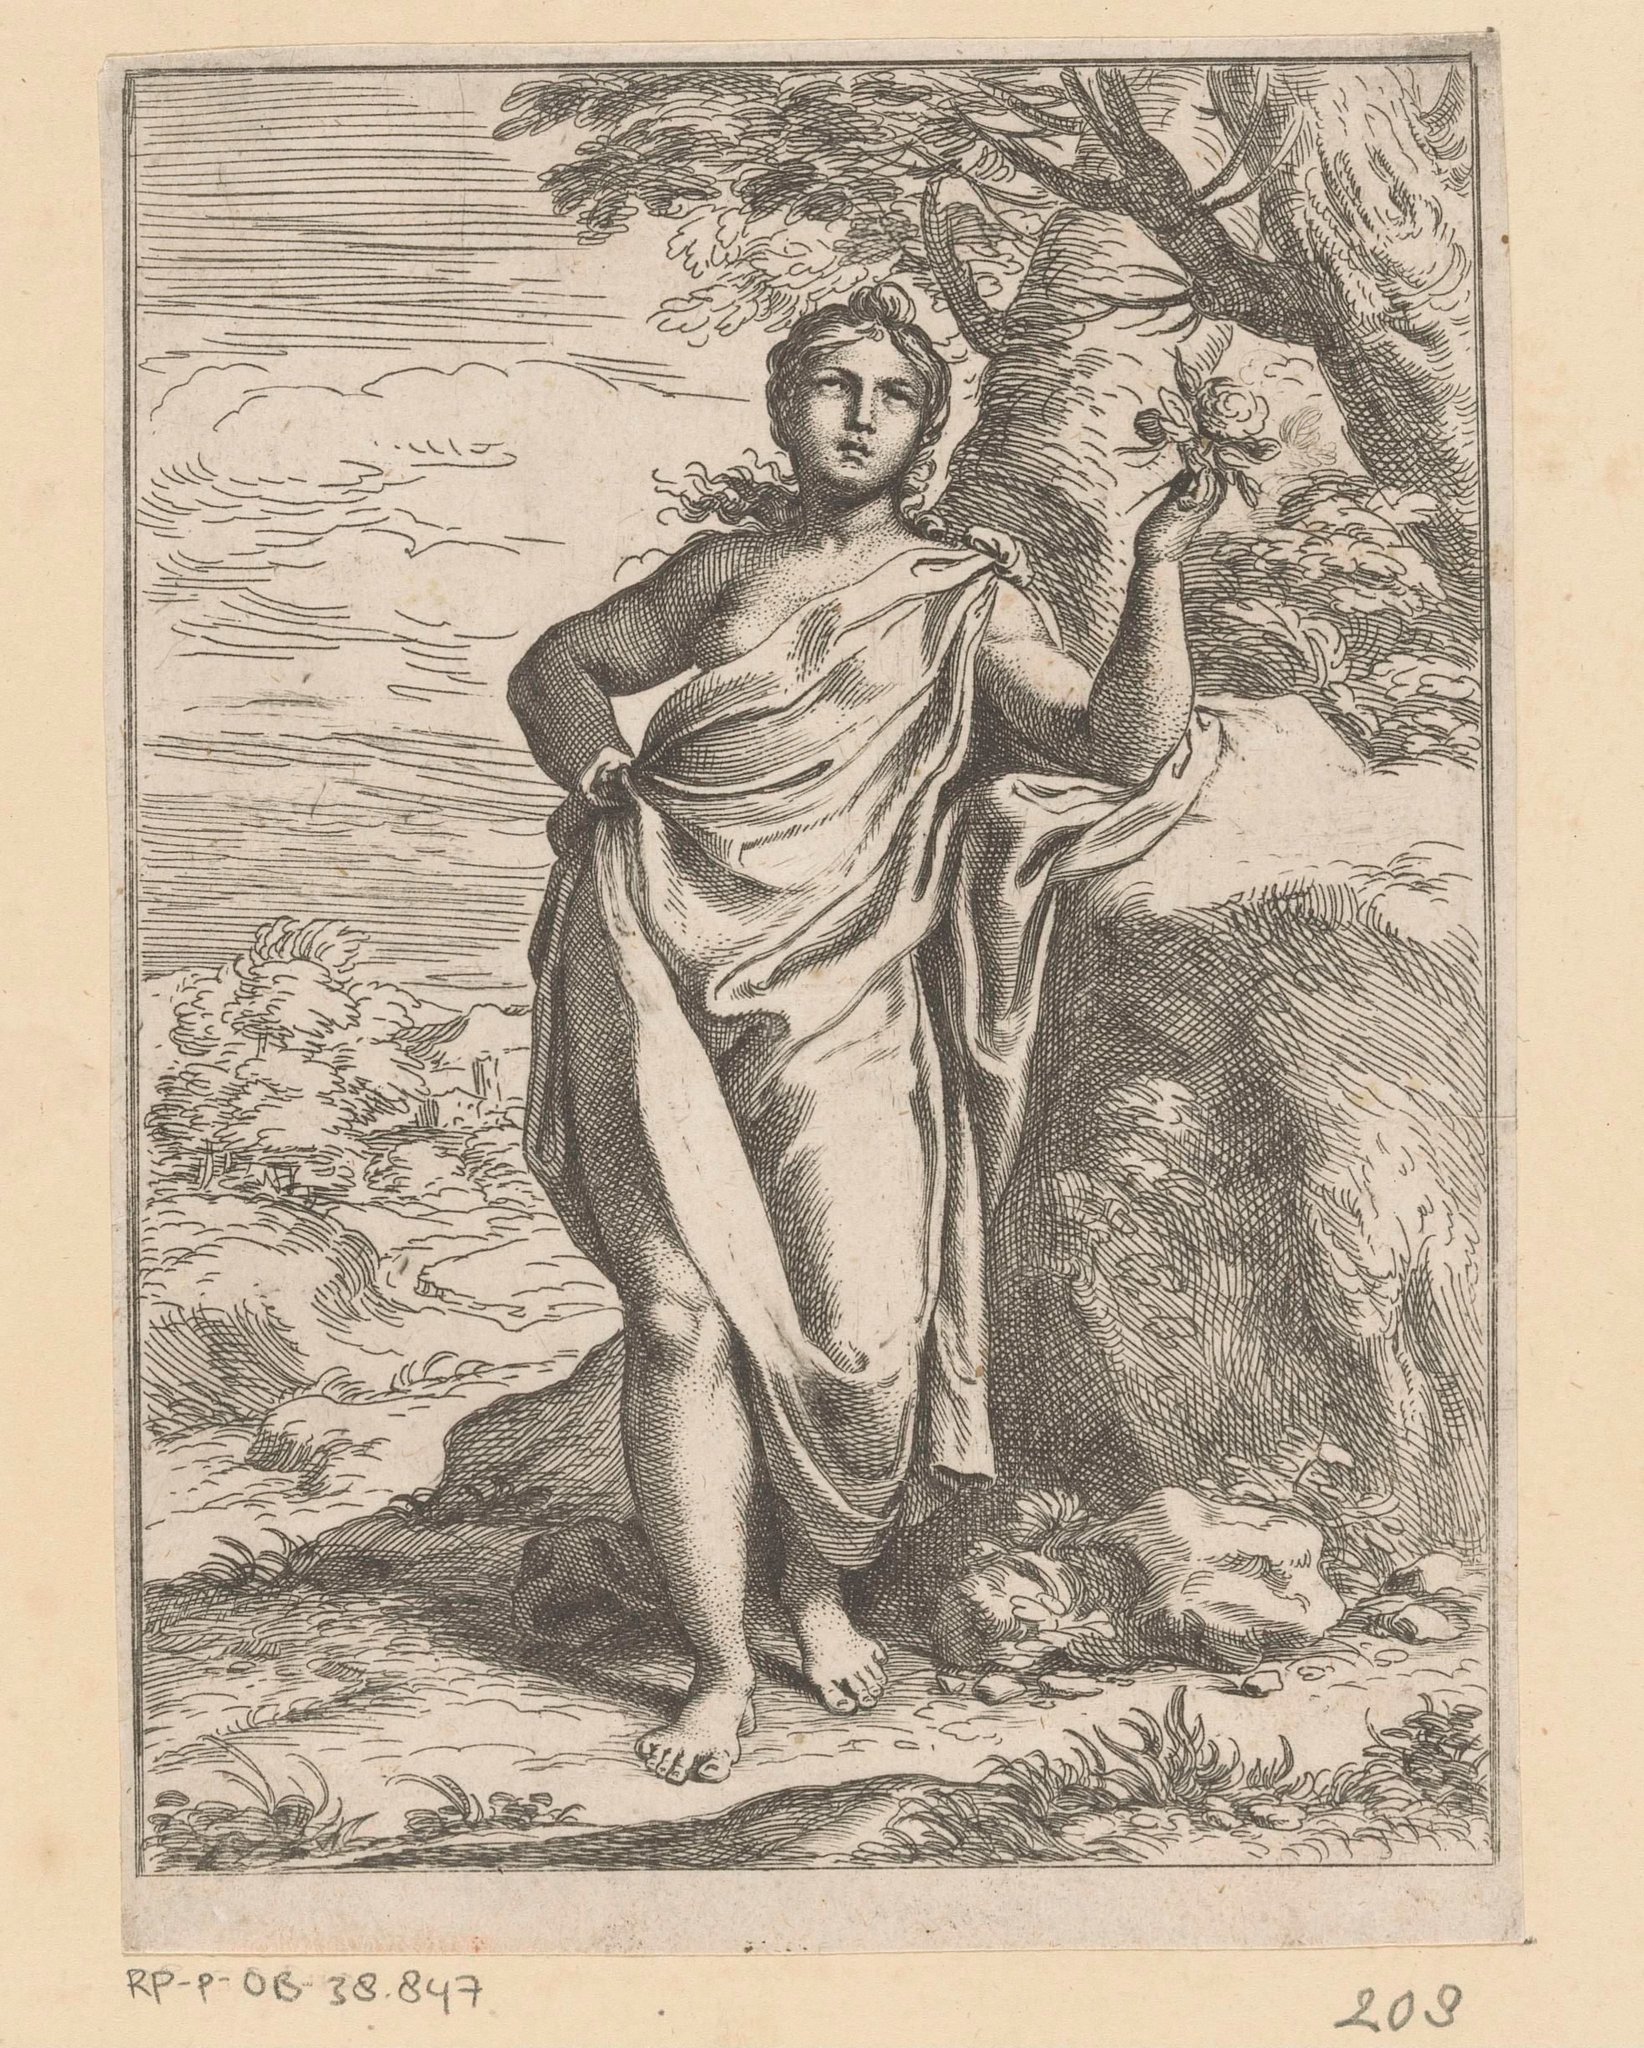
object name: print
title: Vrouw met bloemen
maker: Anonymous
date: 1550-1649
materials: paper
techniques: etching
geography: italy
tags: city-view, and landscape with man-made constructions, adolescent, young woman, maiden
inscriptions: collector's mark: Lugt 240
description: Een staande vrouw in een landschap met bloemen in de hand.